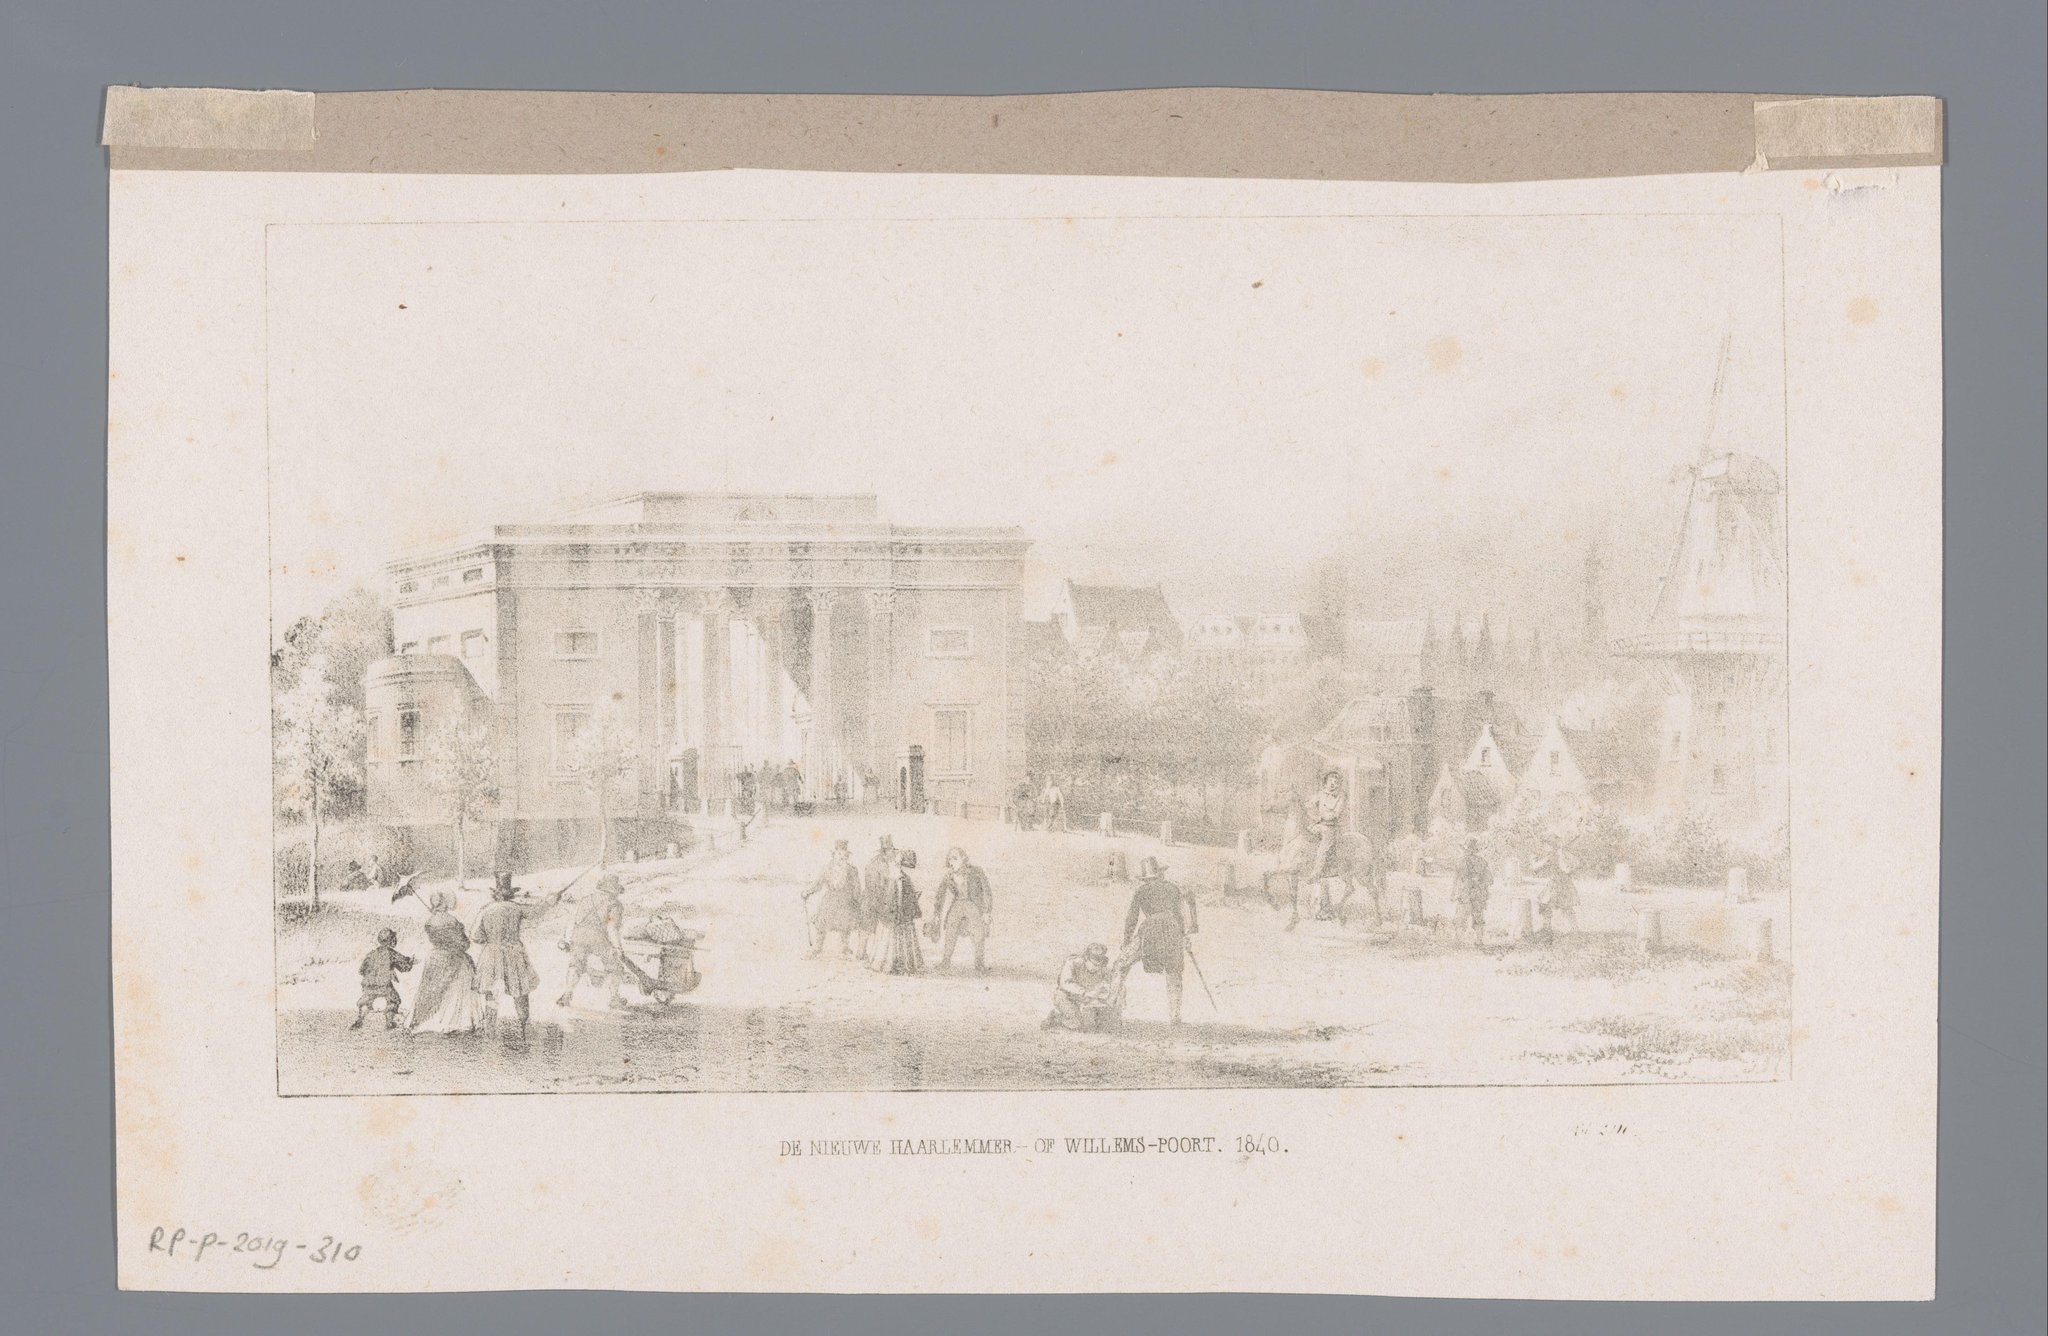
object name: book illustration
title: De Nieuwe Haarlemmer- of Willems-poort. 1840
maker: johannes hilverdink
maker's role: draughtsman, painter, print maker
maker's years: 1813-1902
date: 1840-1866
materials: paper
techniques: lithograph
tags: city-gate, amsterdam